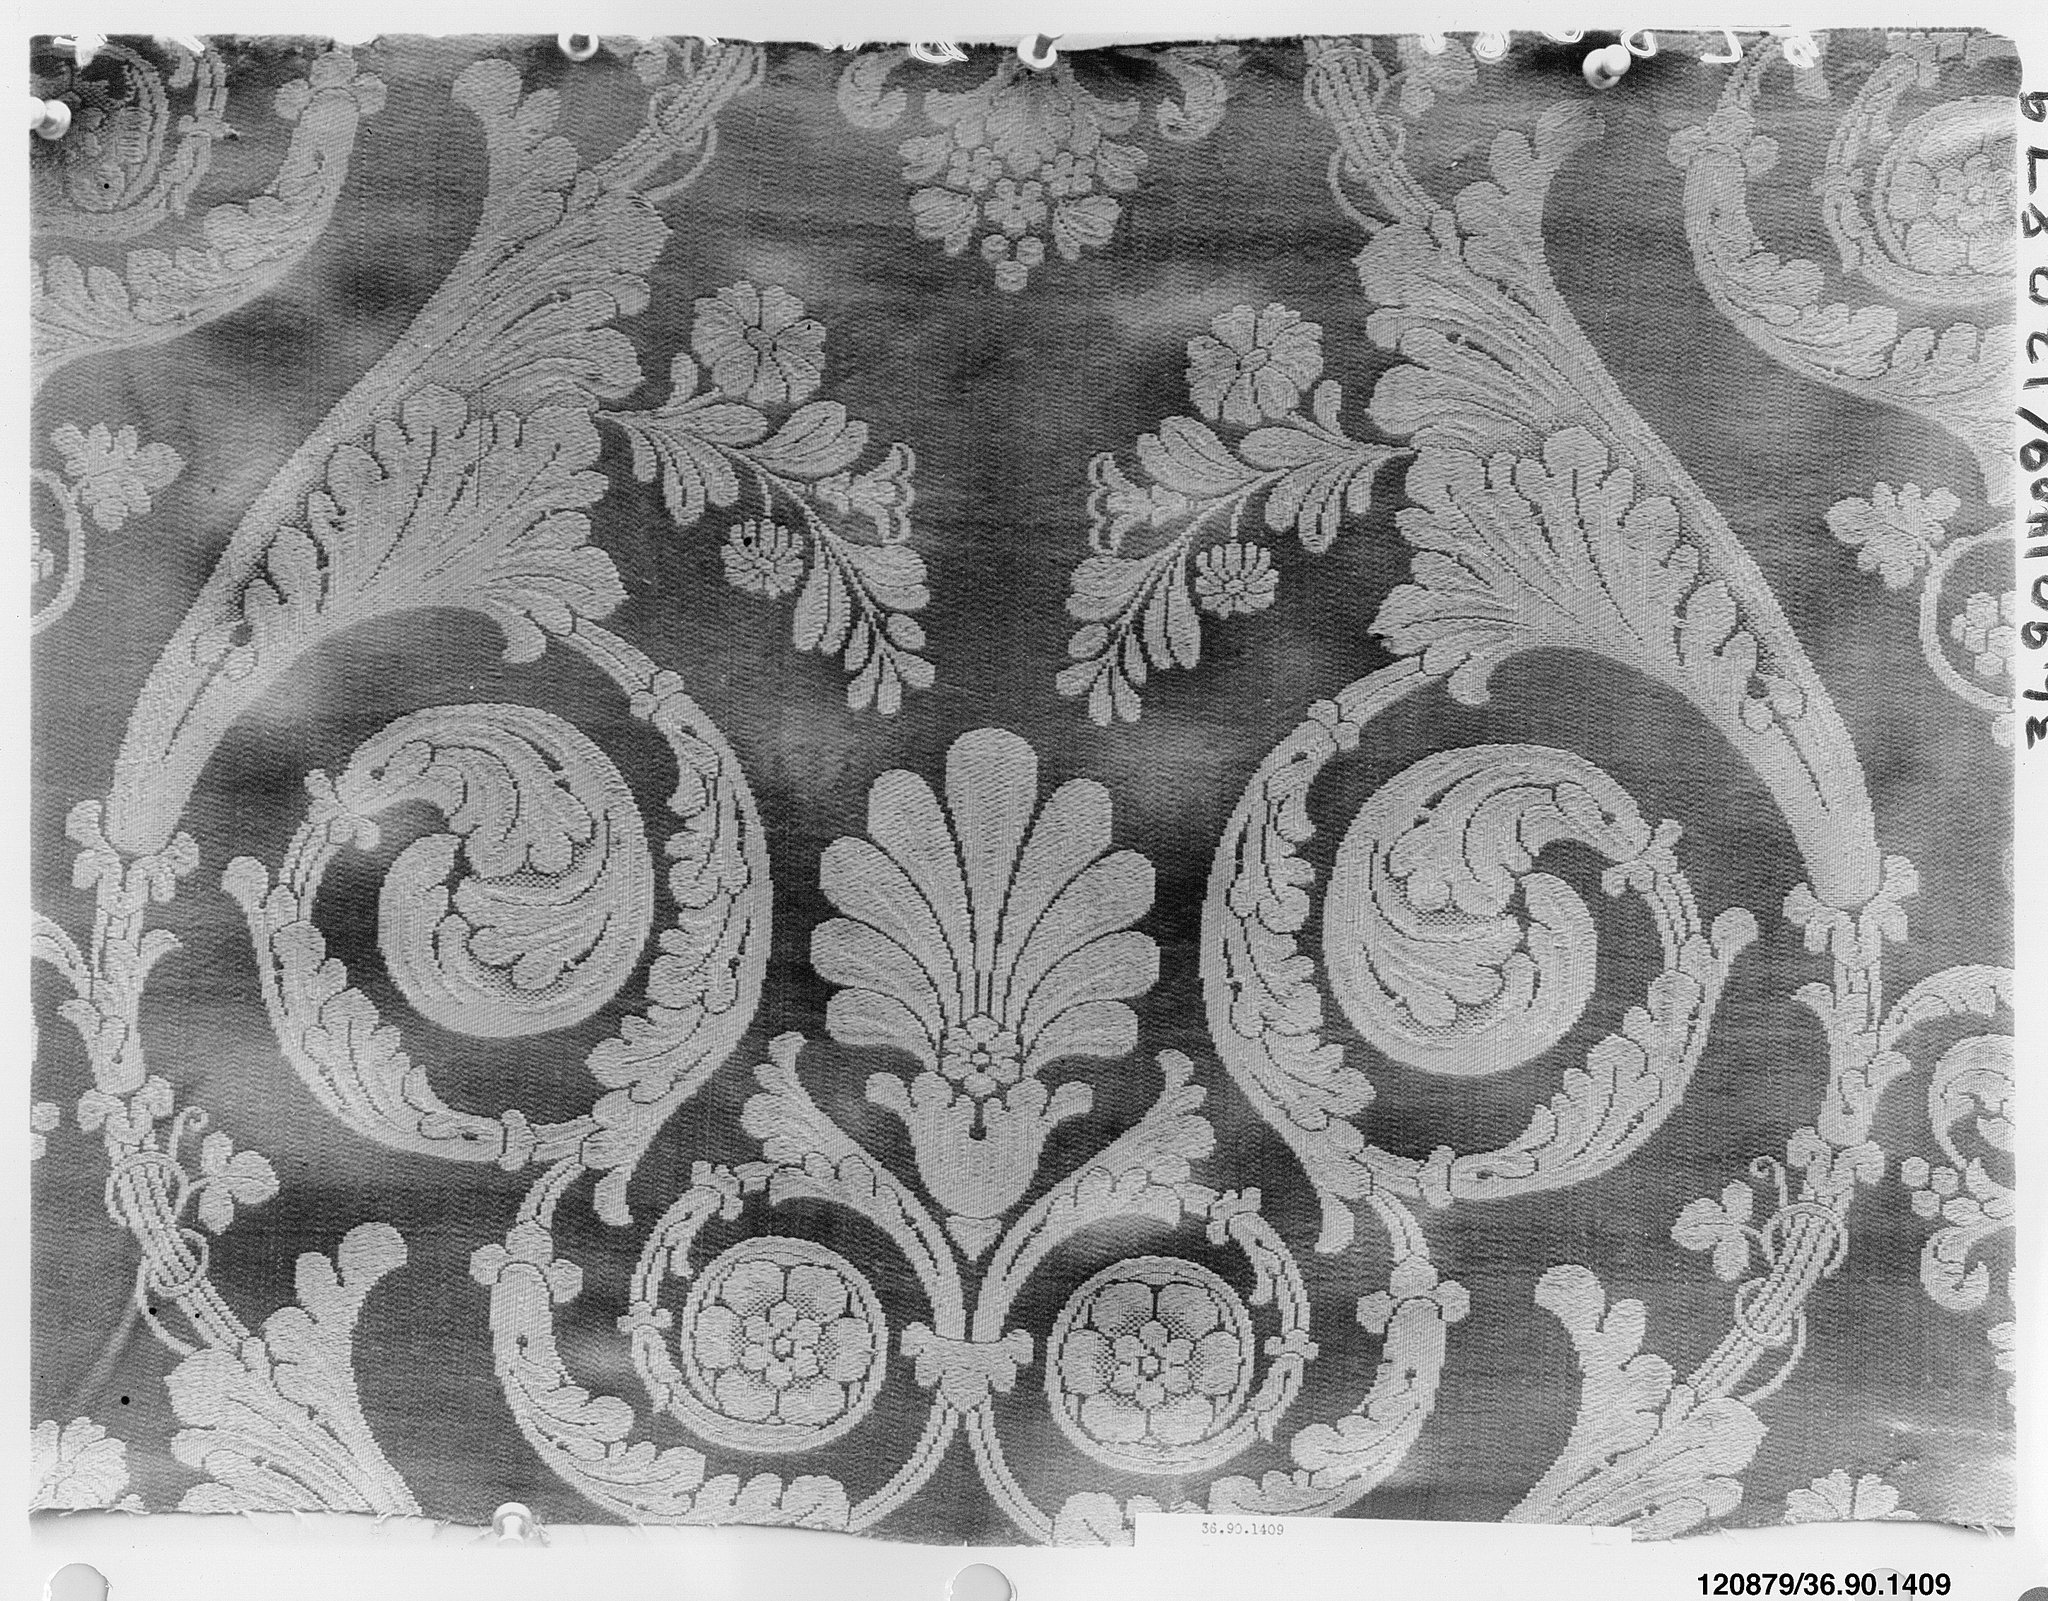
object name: piece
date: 1830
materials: silk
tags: leaves